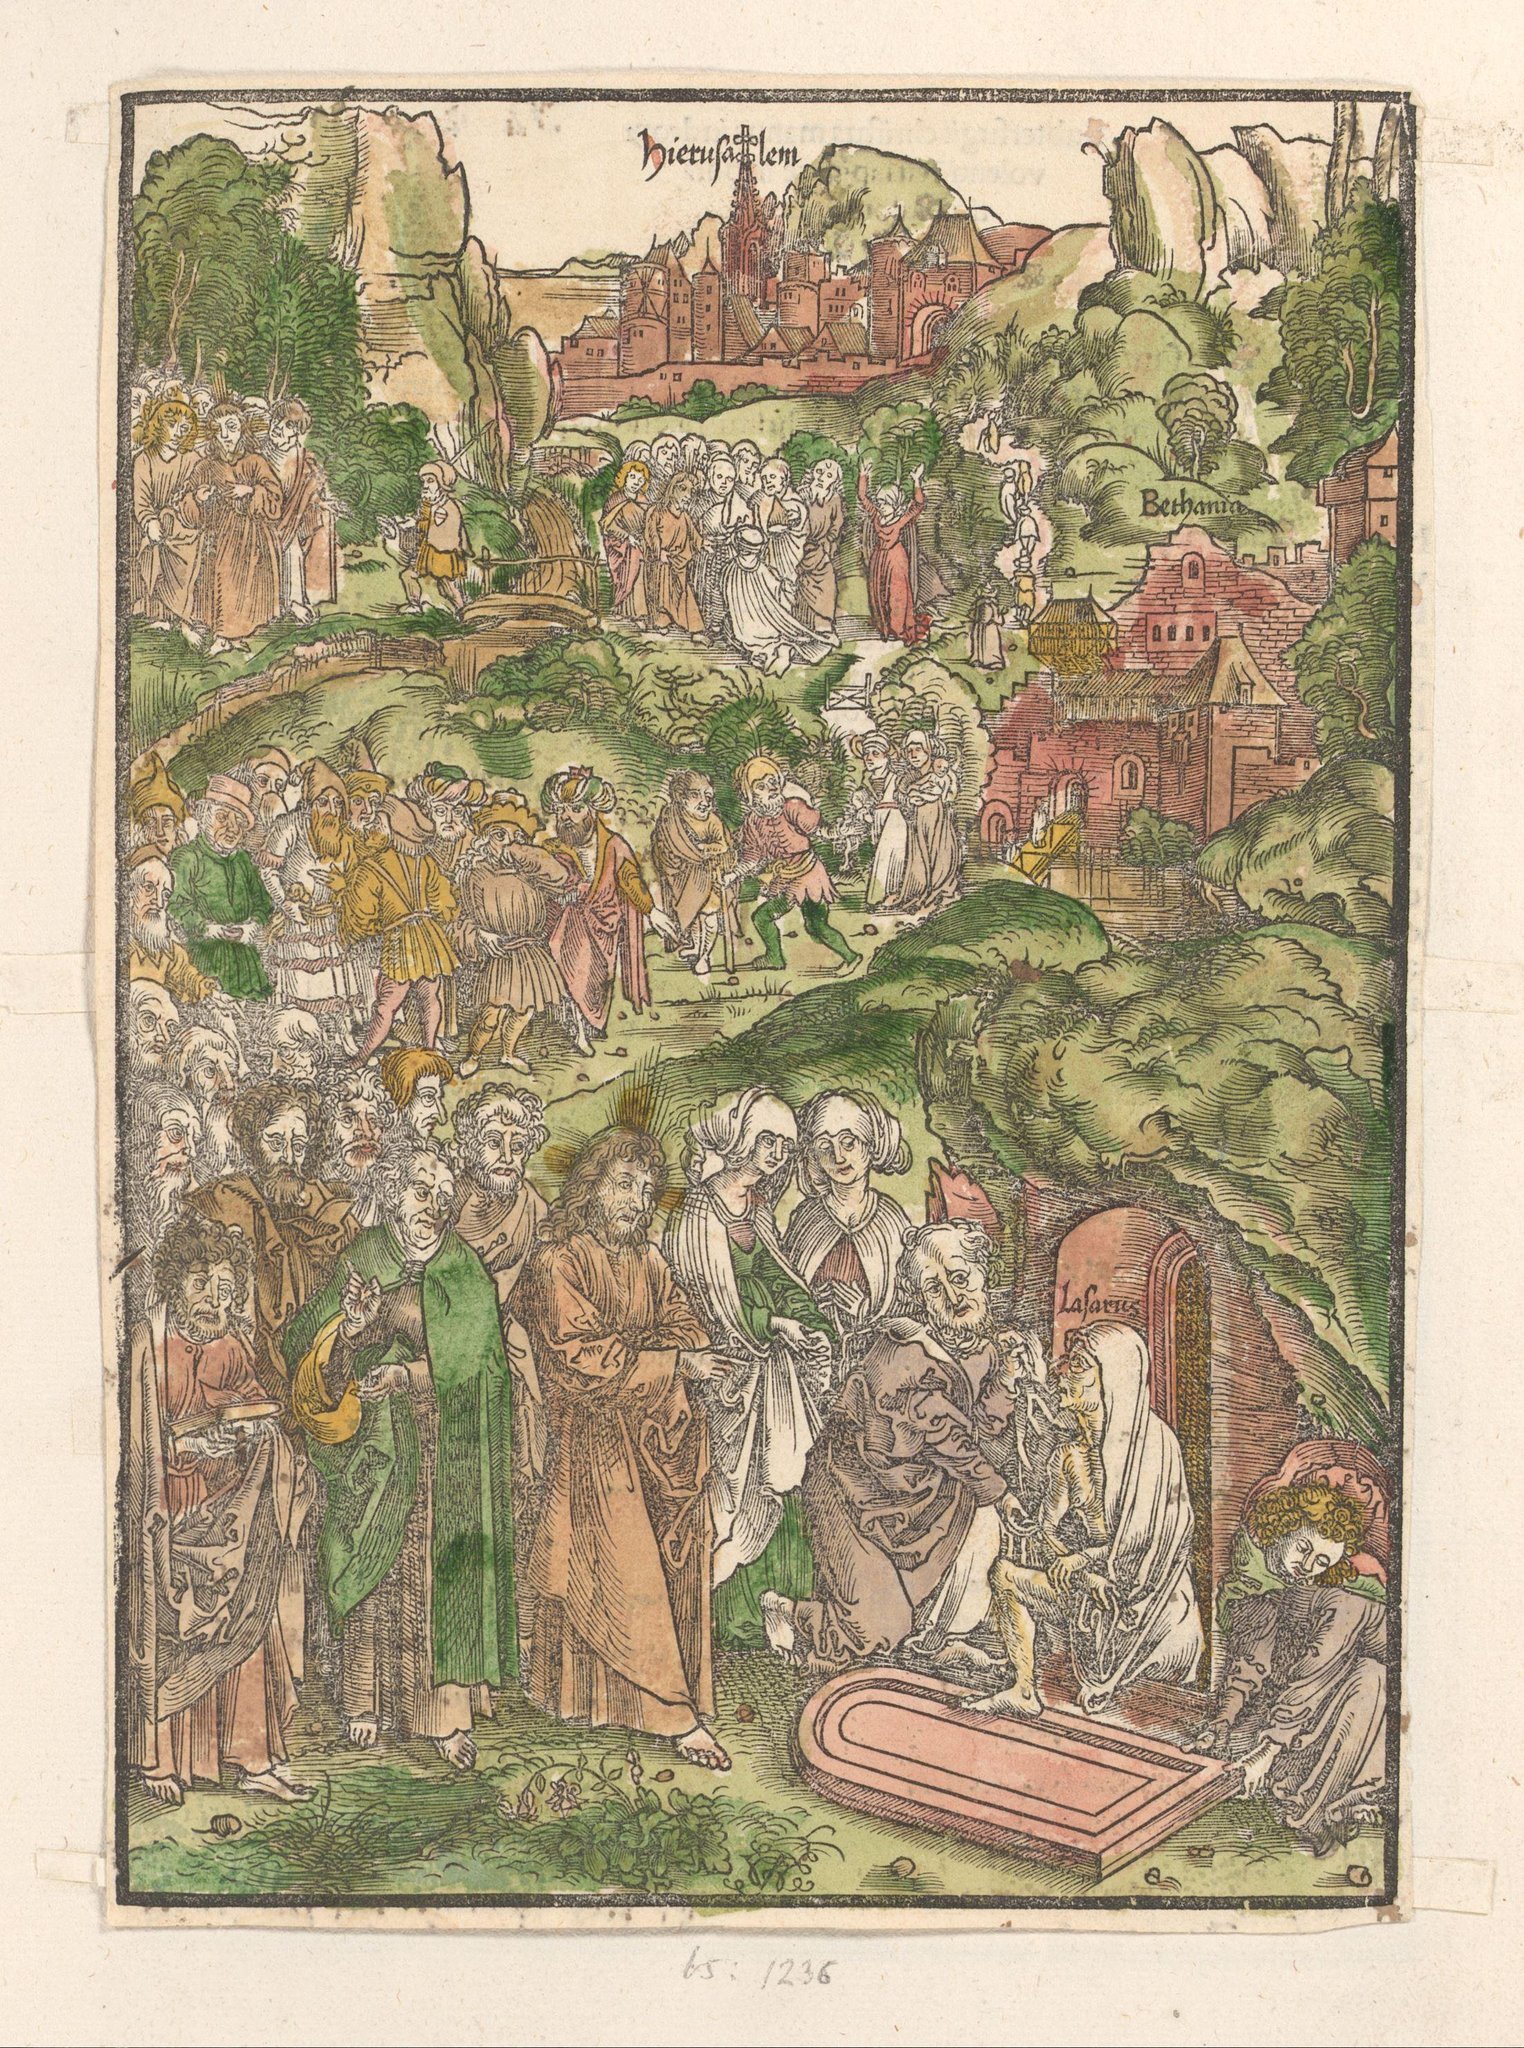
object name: print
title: Opwekking van Lazarus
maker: urs graf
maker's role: draughtsman, print maker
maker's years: 1485-1528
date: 1506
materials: paper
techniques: woodcut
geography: switzerland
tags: the raising of lazarus ('lazarus, come out')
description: Christus wekt Lazarus op uit de dood. Hij staat tegenover het graf en wijst op Lazarus, die door Petrus uit het graf wordt geholpen. Johannes heeft de deur van het graf geopend. De discipelen kijken toe. Op de achtergrond de scènes die vooraf ging: Marta komt op de weg tussen Betanië en Jeruzalem met opgeheven armen naar Christus en vertelt hem dat Lazarus is gestorven. Prent maakt deel uit van een album.